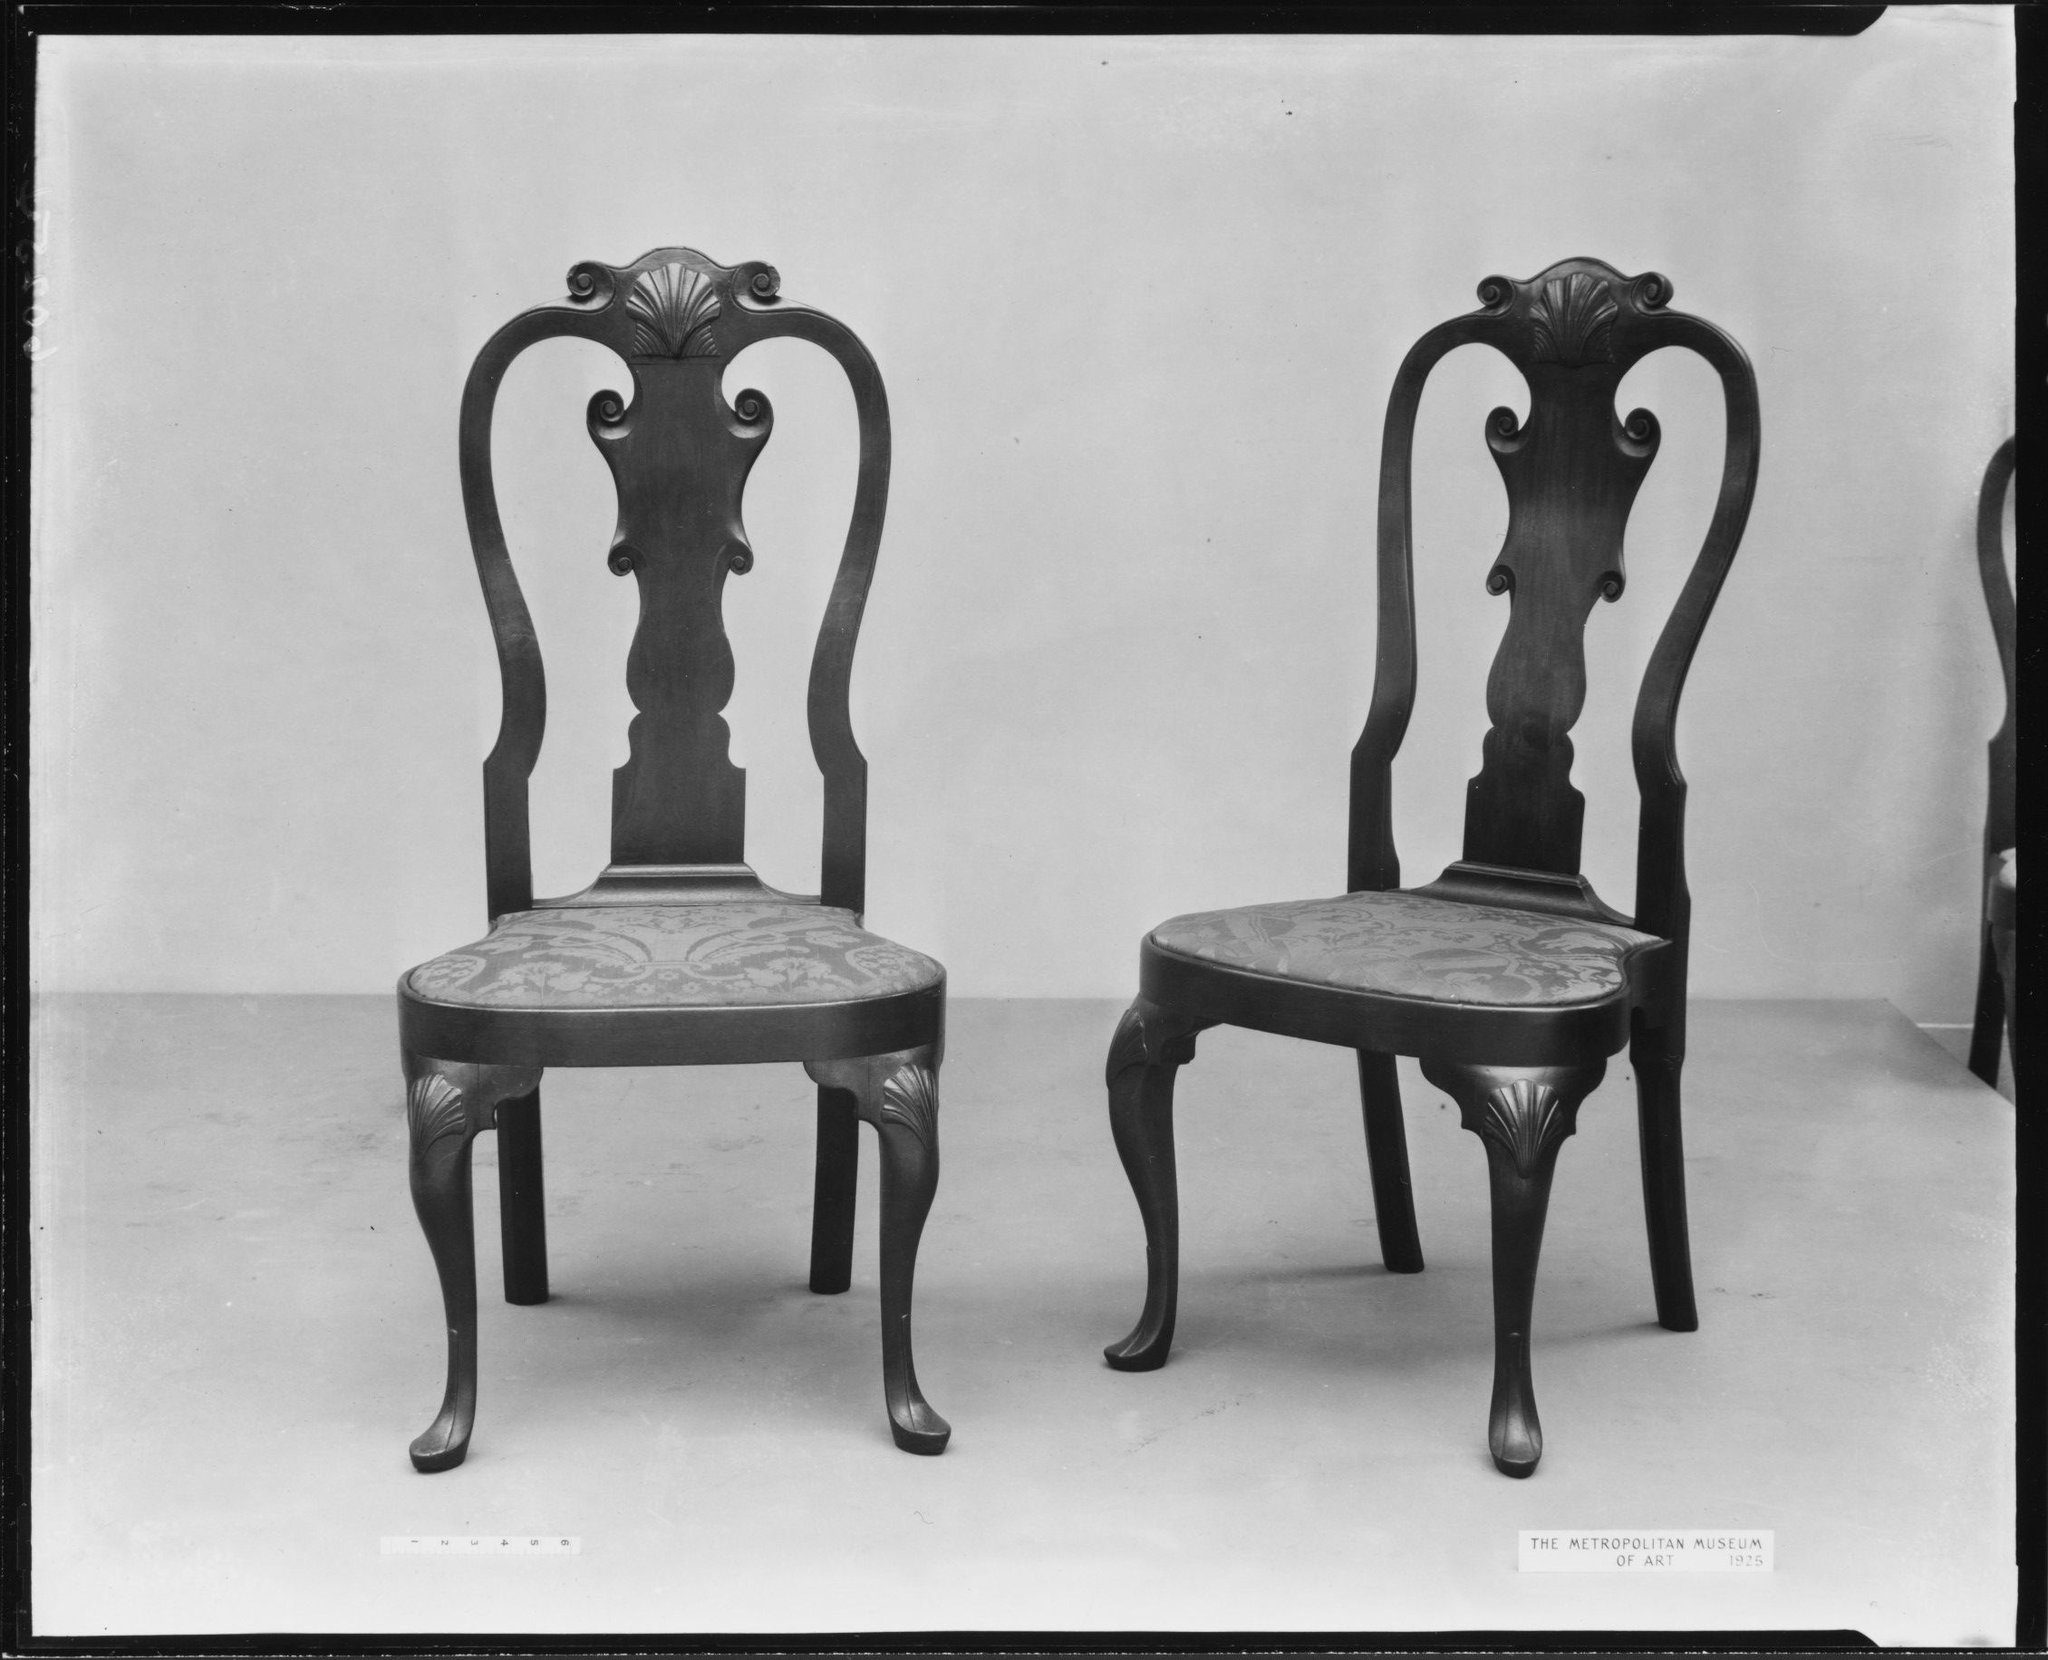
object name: side chair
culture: american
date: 1740-1760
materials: wood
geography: united states